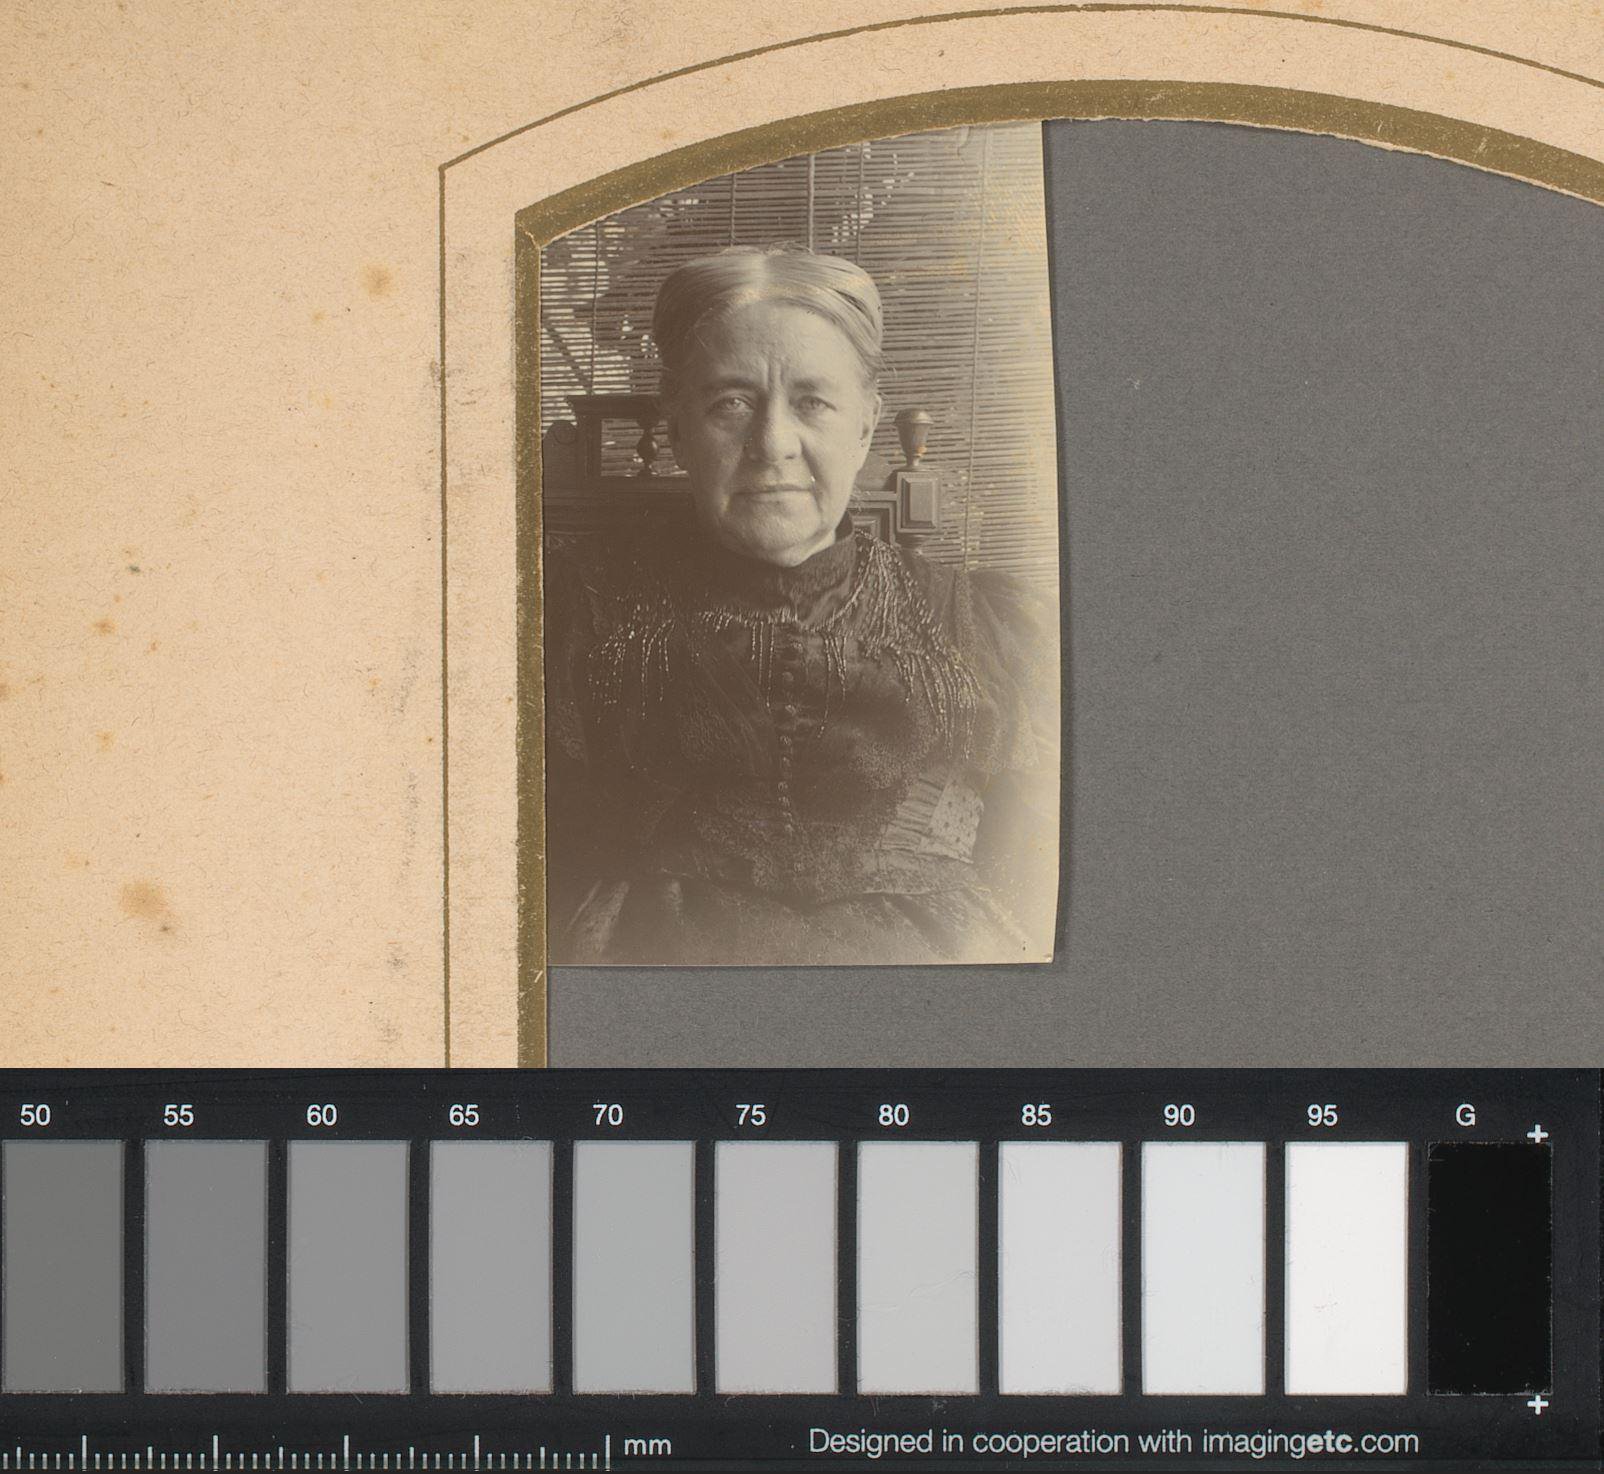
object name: album leaf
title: Portret van een vrouw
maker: Anonymous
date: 1880-1910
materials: cardboard, photographic support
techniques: gelatin silver print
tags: historical persons - bb - woman